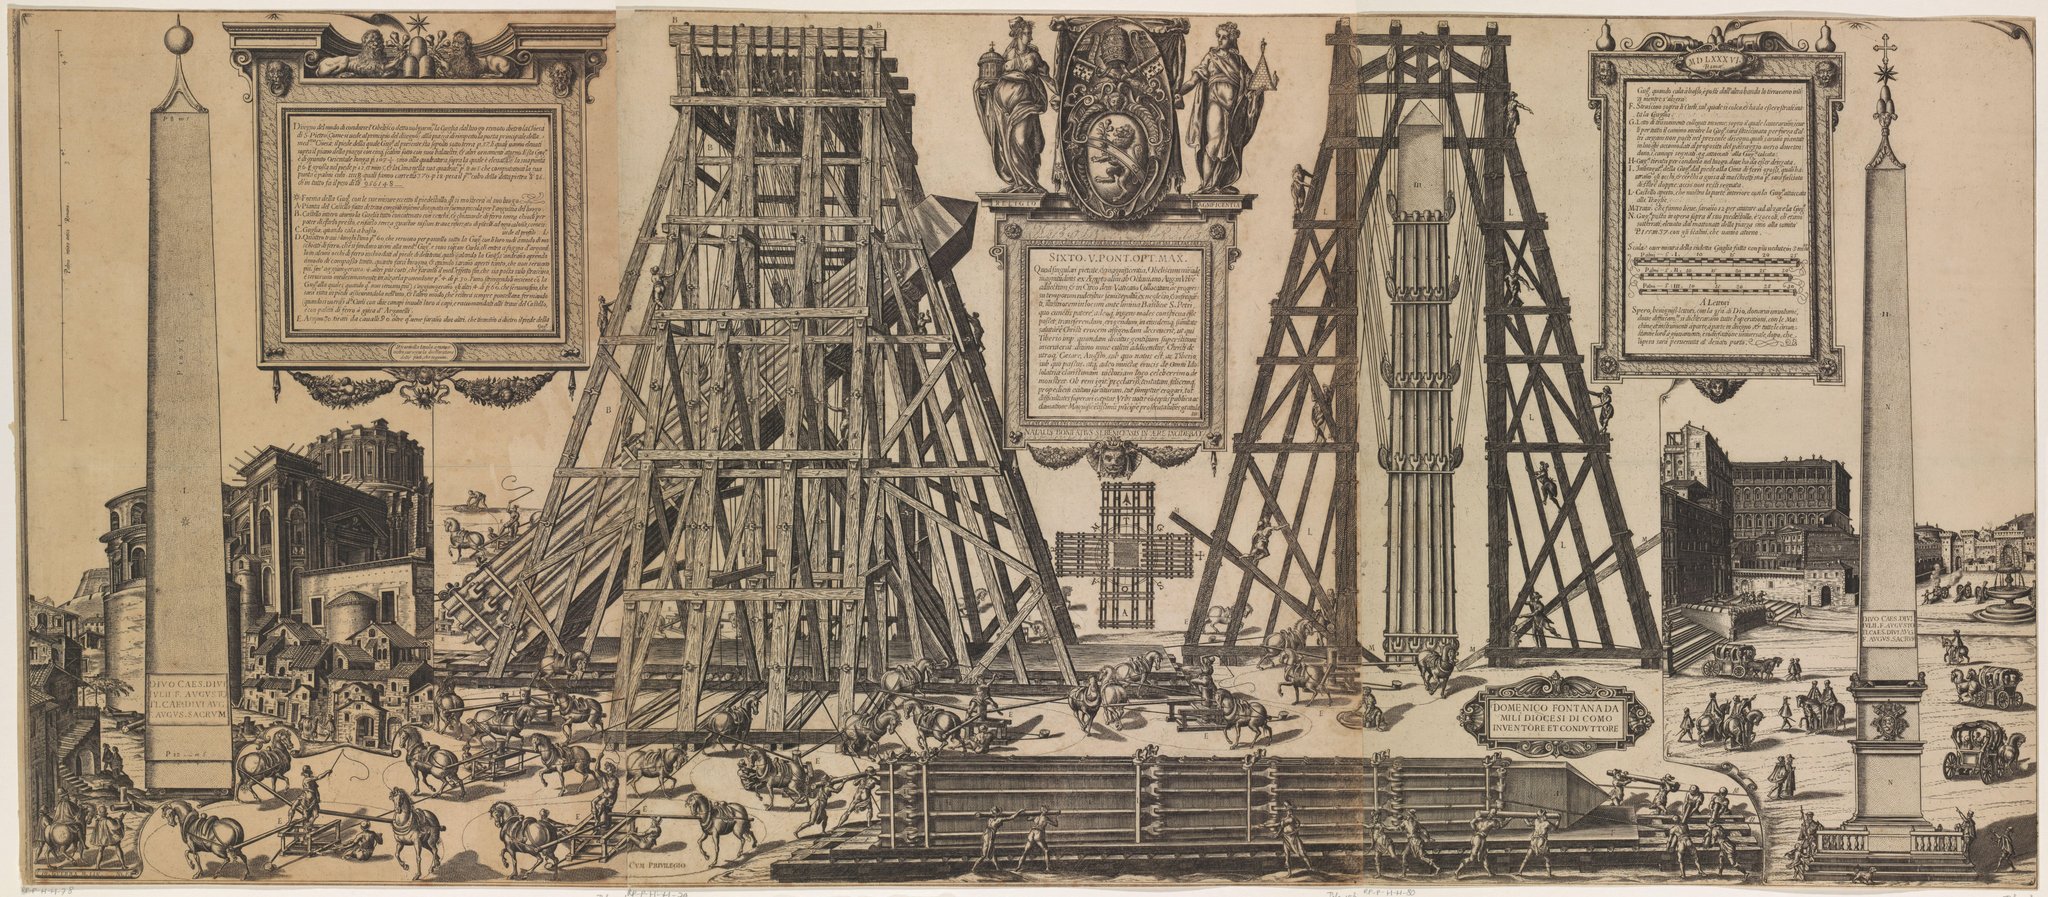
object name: print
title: De oprichting van de obelisk op het St. Pietersplein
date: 1586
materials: paper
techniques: engraving, etching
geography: rome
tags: rome, sixtus v, switzerland, naples, domenico fontana, obelisk, needle, roman catholic church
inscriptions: collector's mark: ‘Hinloopen’, collector's mark: Lugt 11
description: Linkerdeel: Links de Vaticaanse Obelisk die rechtop staat, bekroond met een koperen bol. Rechts mannen en paarden die de Vaticaanse Obelisk op zijn nieuwe verblijfplaats, het St. Pietersplein, rechtop zetten met behulp van een houten stellage. Rechtsboven een sierlijst met tekst. Middelste deel: Mannen en paarden zijn bezig met het oprichten van de Vaticaanse Obelisk (in 1586) op het Sint-Pietersplein, met behulp van een grote houten stellage. Rechtsboven een sierlijst met tekst, het wapen van paus Sixtus V en personificaties van Religie en Grootsheid. Rechtsonder mannen die de obelisk transporteren met behulp van ronde palen. Rechterdeel: Links de Vaticaanse Obelisk die rechtop staat. Om de obelisk is een houten stellage gebouwd. Linksonder mannen die de obelisk transporteren met behulp van ronde palen. Rechts de Vaticaanse Obelisk op het Sint-Pietersplein, bekroond met een kruis. Boven, in het midden, een sierlijst met verklarende lijst met letters.